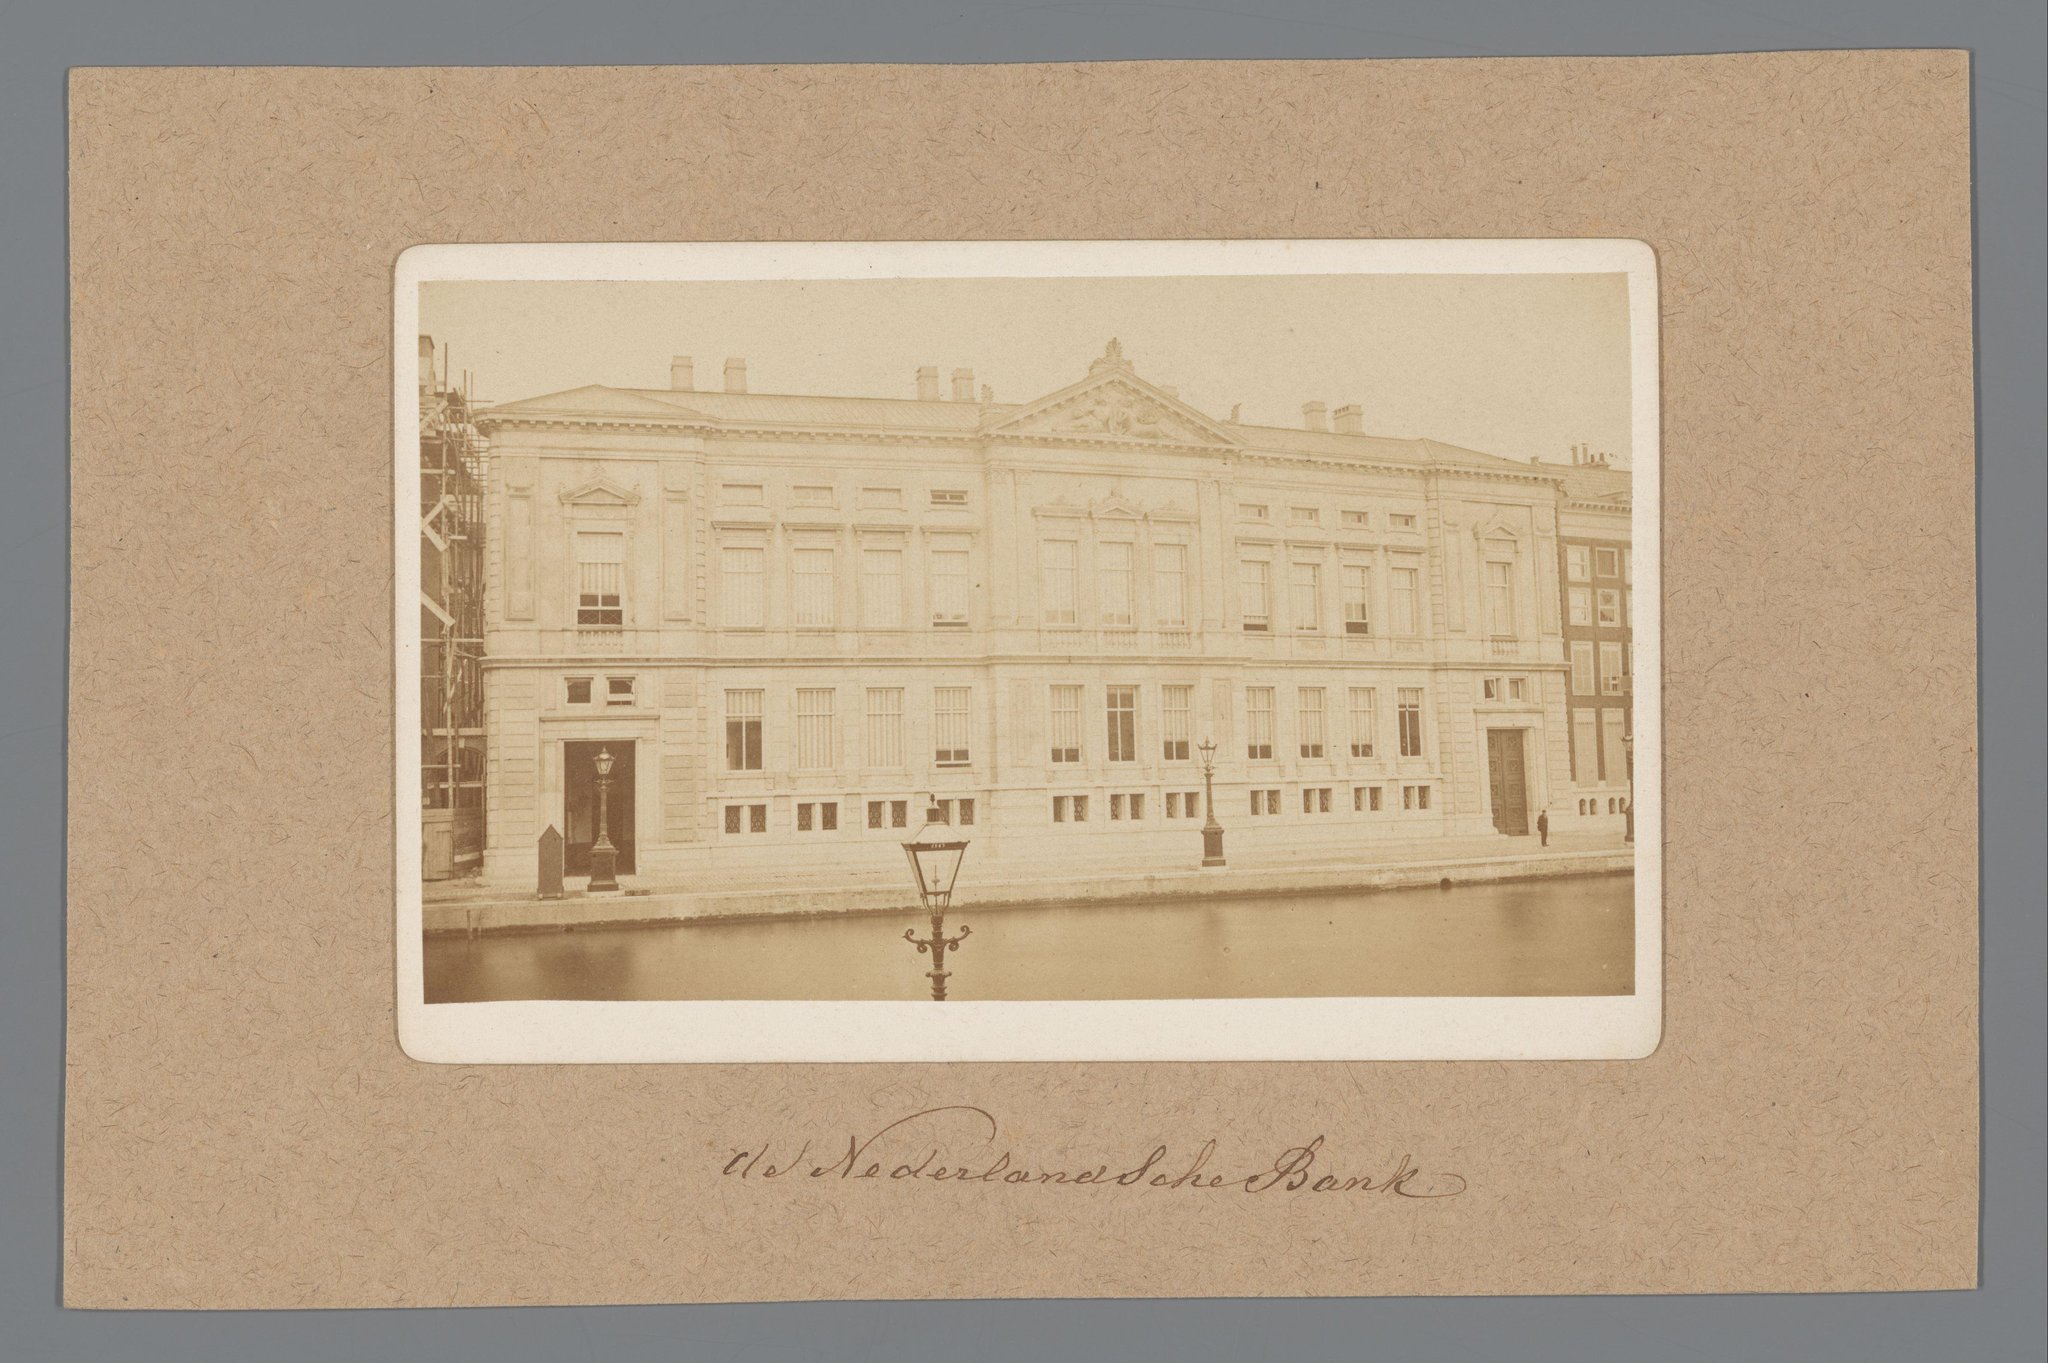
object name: photograph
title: Façade van Oude Turfmarkt 127 te Amsterdam, voormalig De Nederlandsche Bank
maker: Anonymous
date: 1870-1890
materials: cardboard, photographic support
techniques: albumen print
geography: amsterdam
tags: bank, civic architecture; edifices; dwellings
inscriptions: annotation: ‘Nederlandsche Bank’